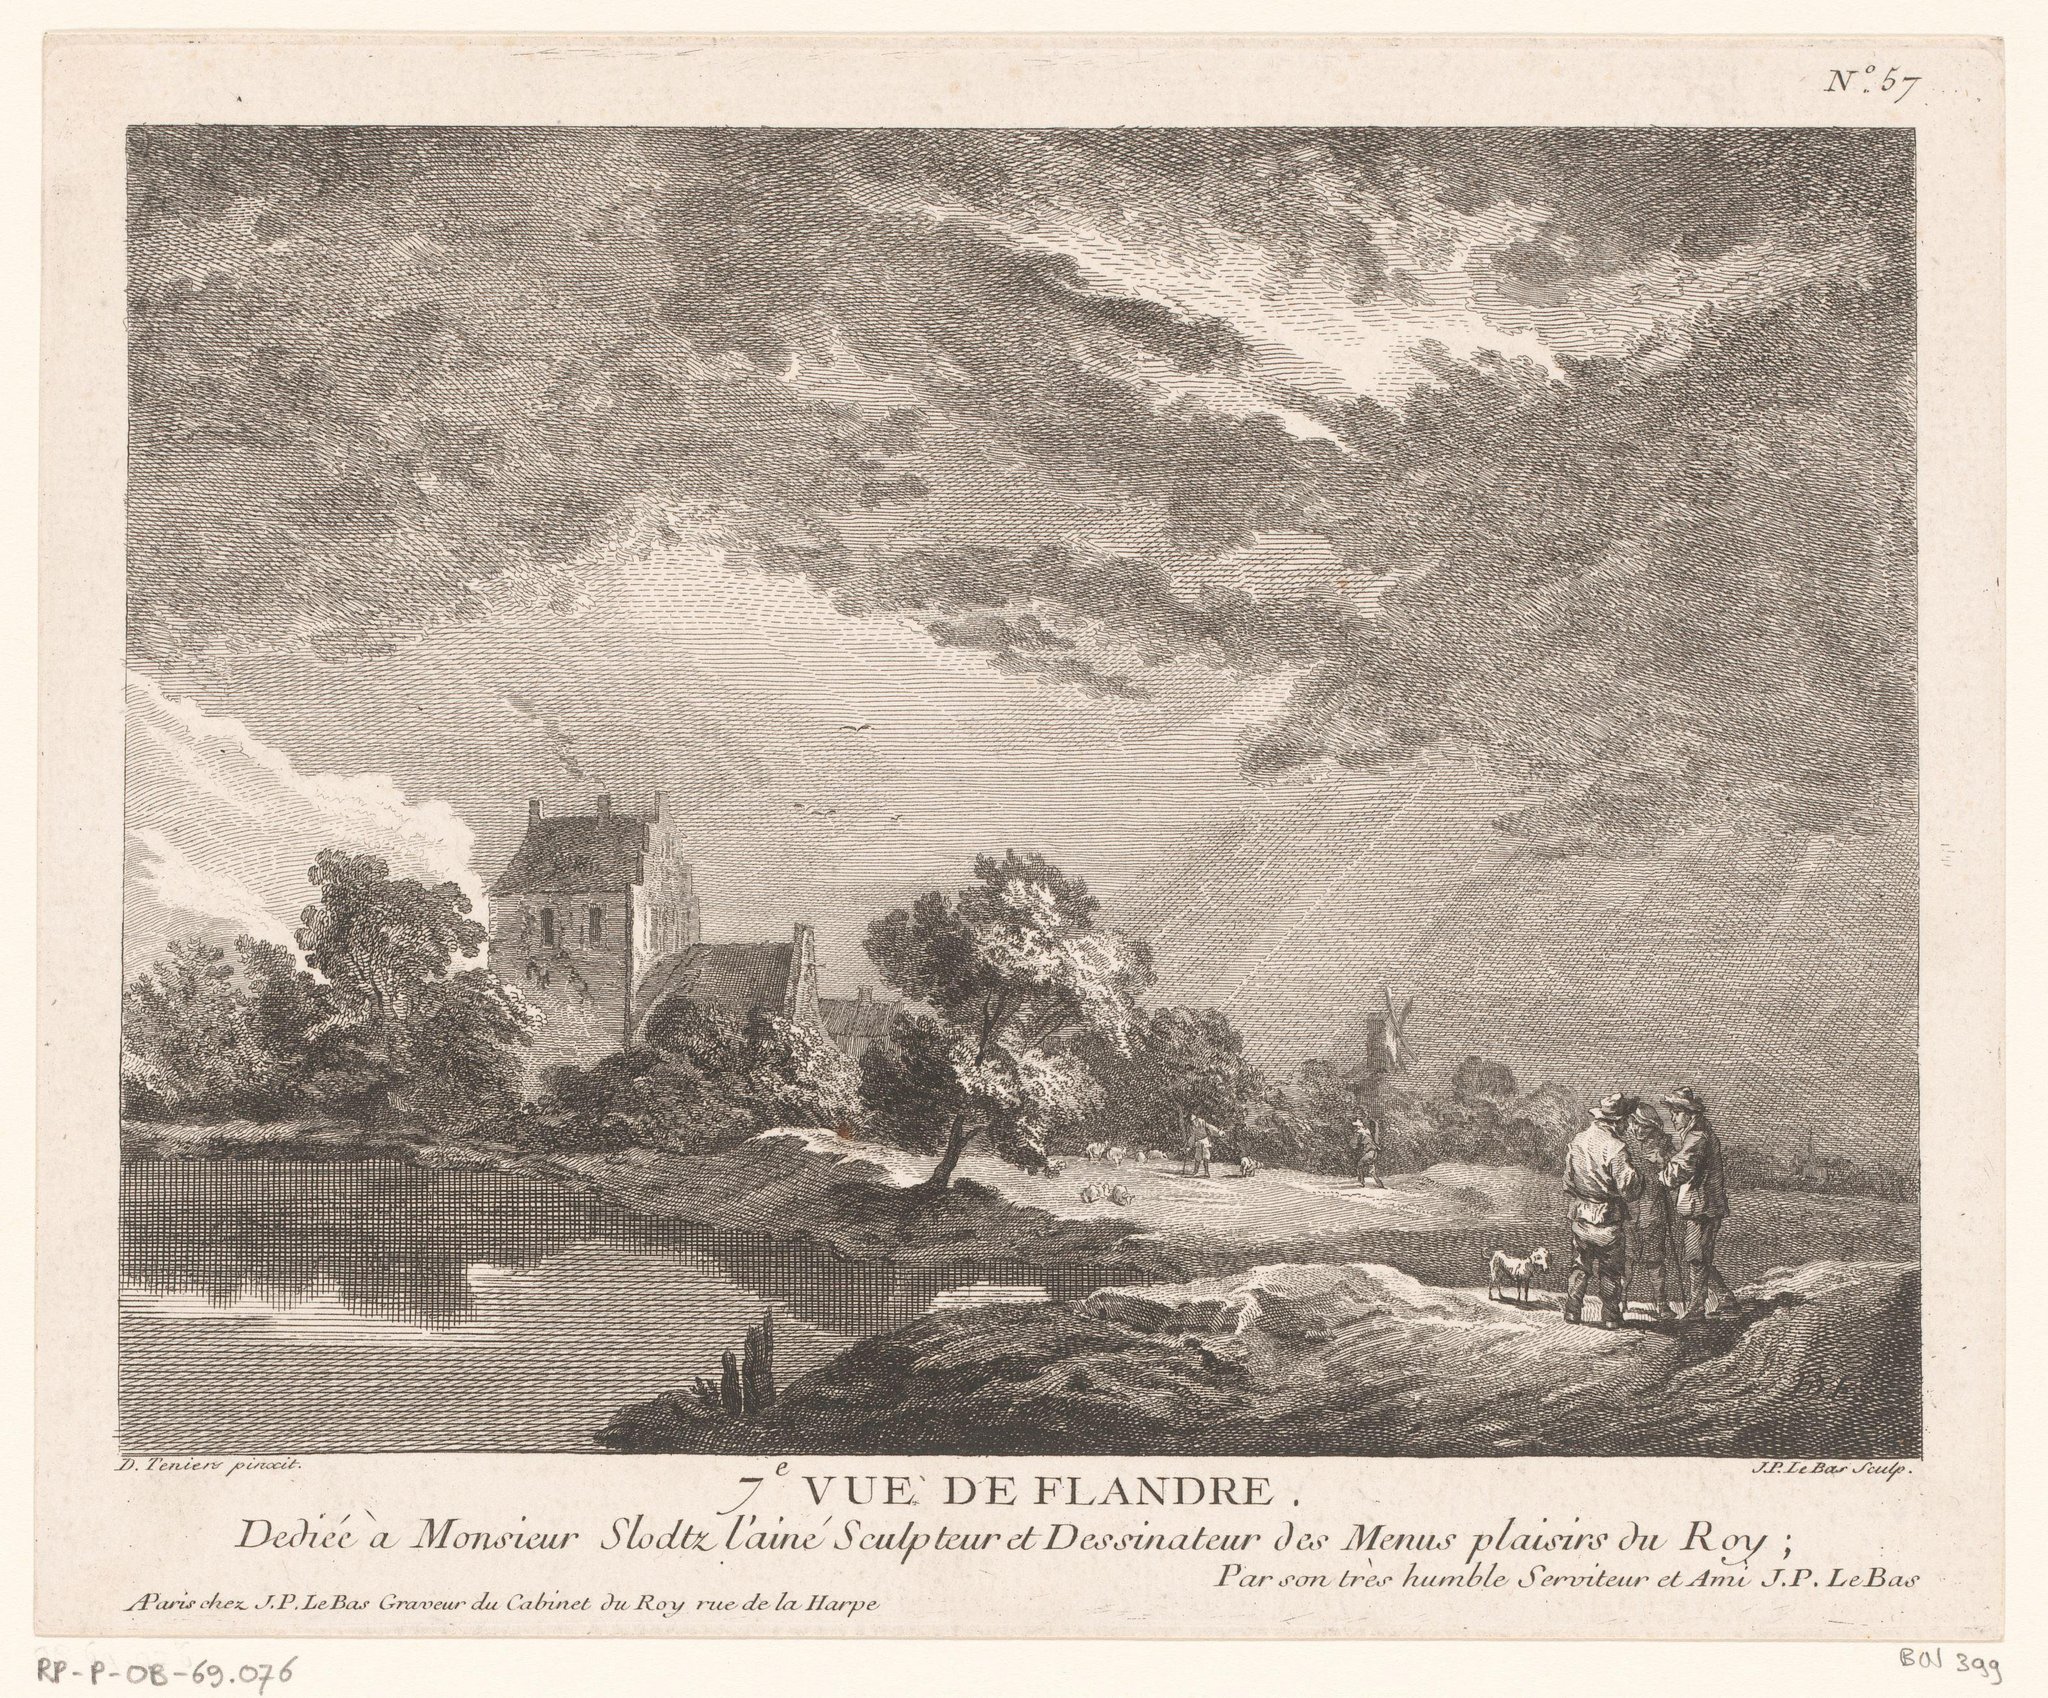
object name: print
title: Rivierlandschap met drie figuren en een hond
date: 1751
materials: paper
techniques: engraving, etching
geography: paris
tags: river, windmill, landscapes (+ landscape with figures, staffage)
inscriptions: collector's mark: Lugt 240